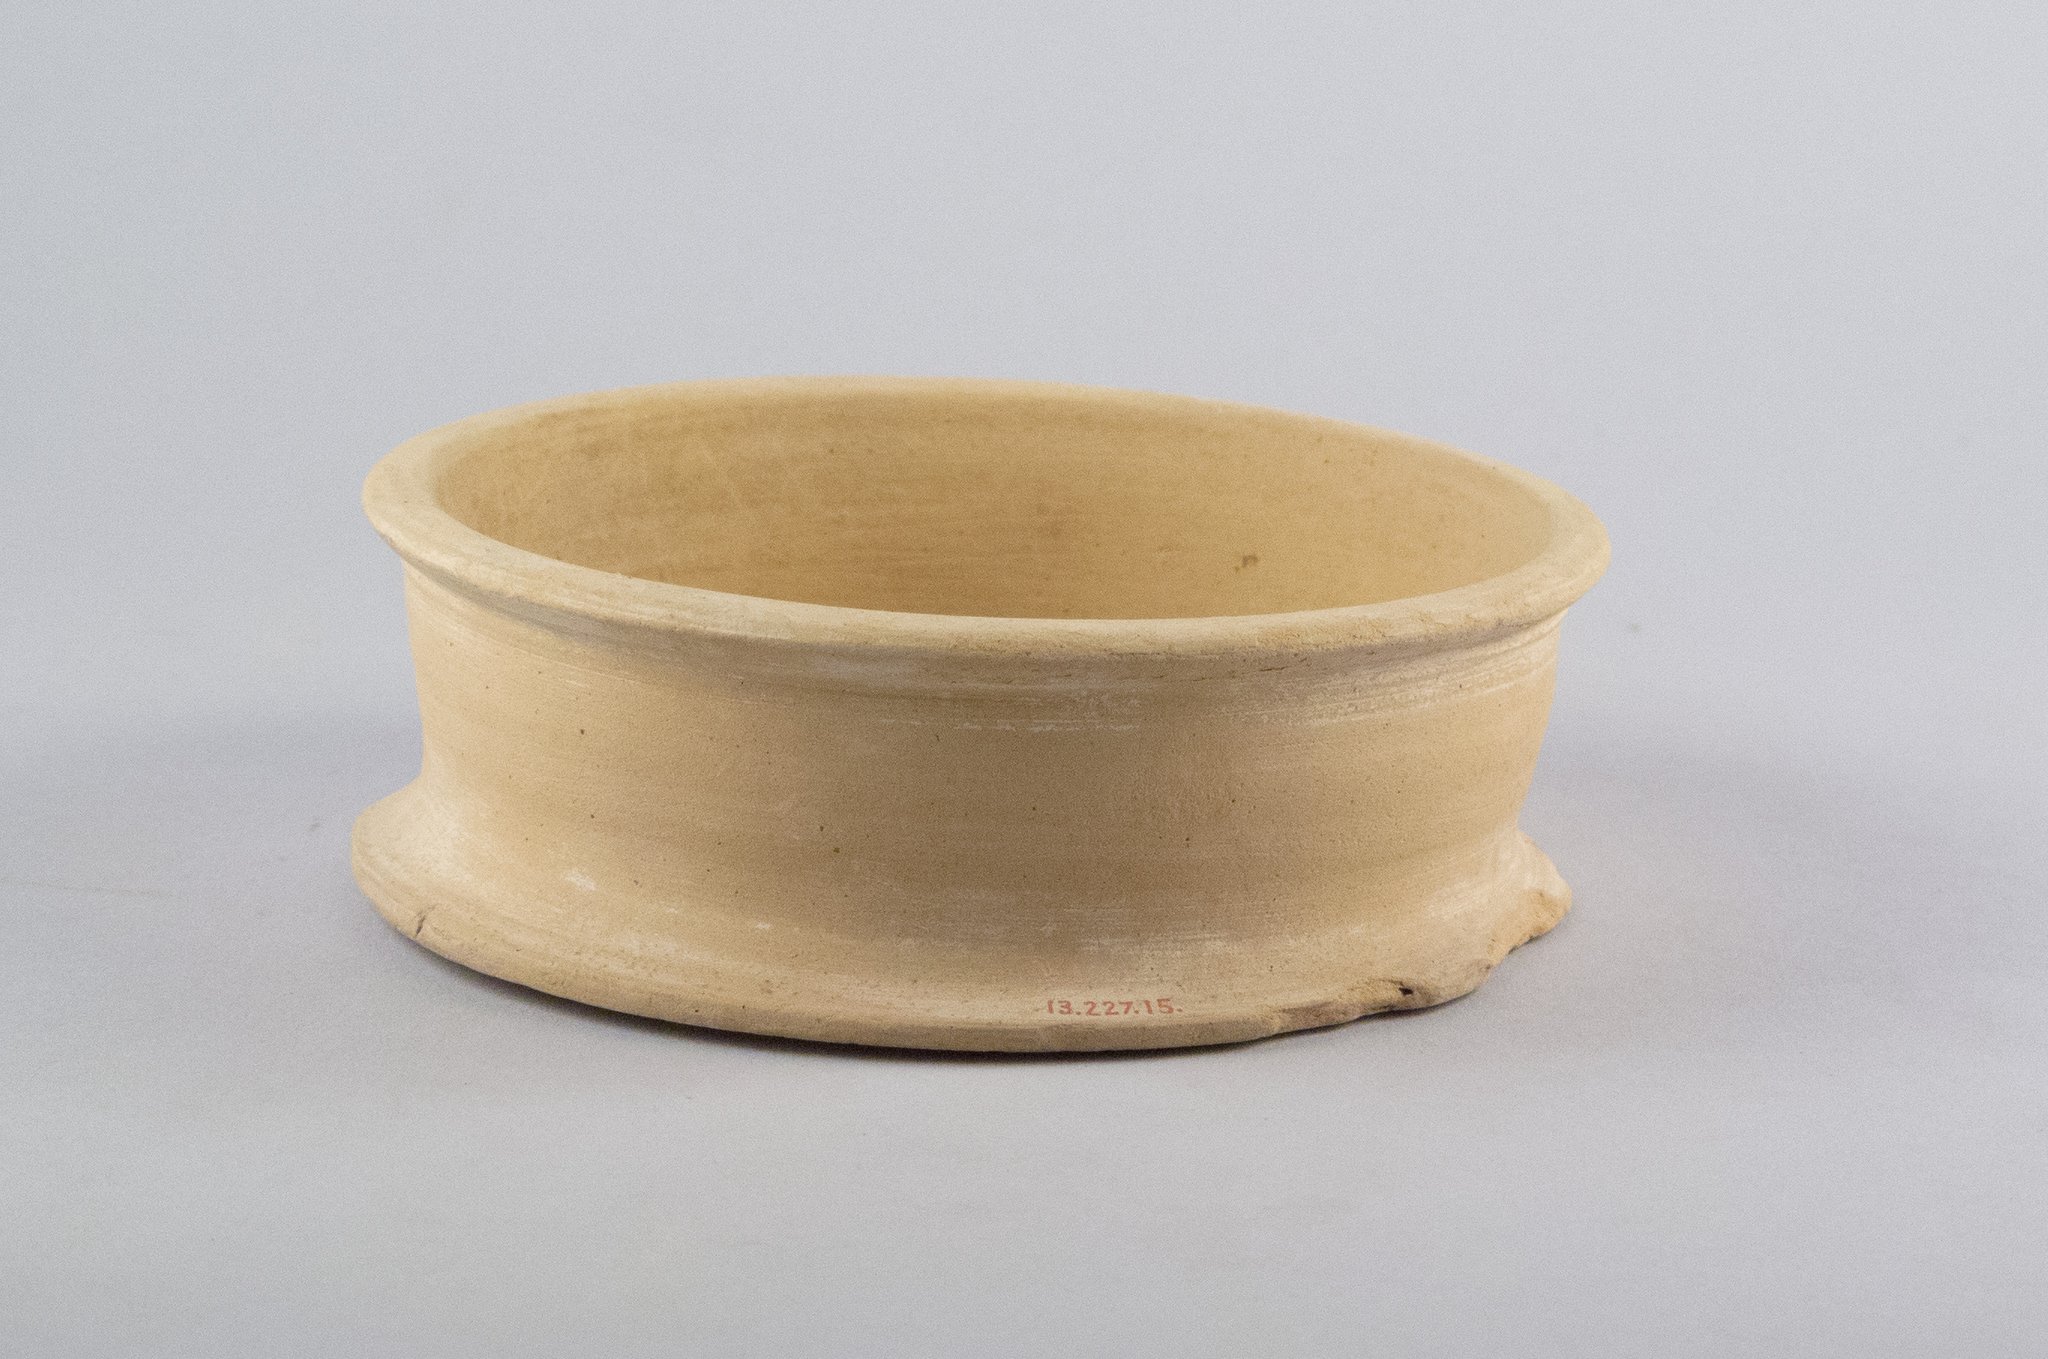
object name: statue base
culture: greek, south italian, tarentine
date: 7000-30 BCE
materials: terracotta